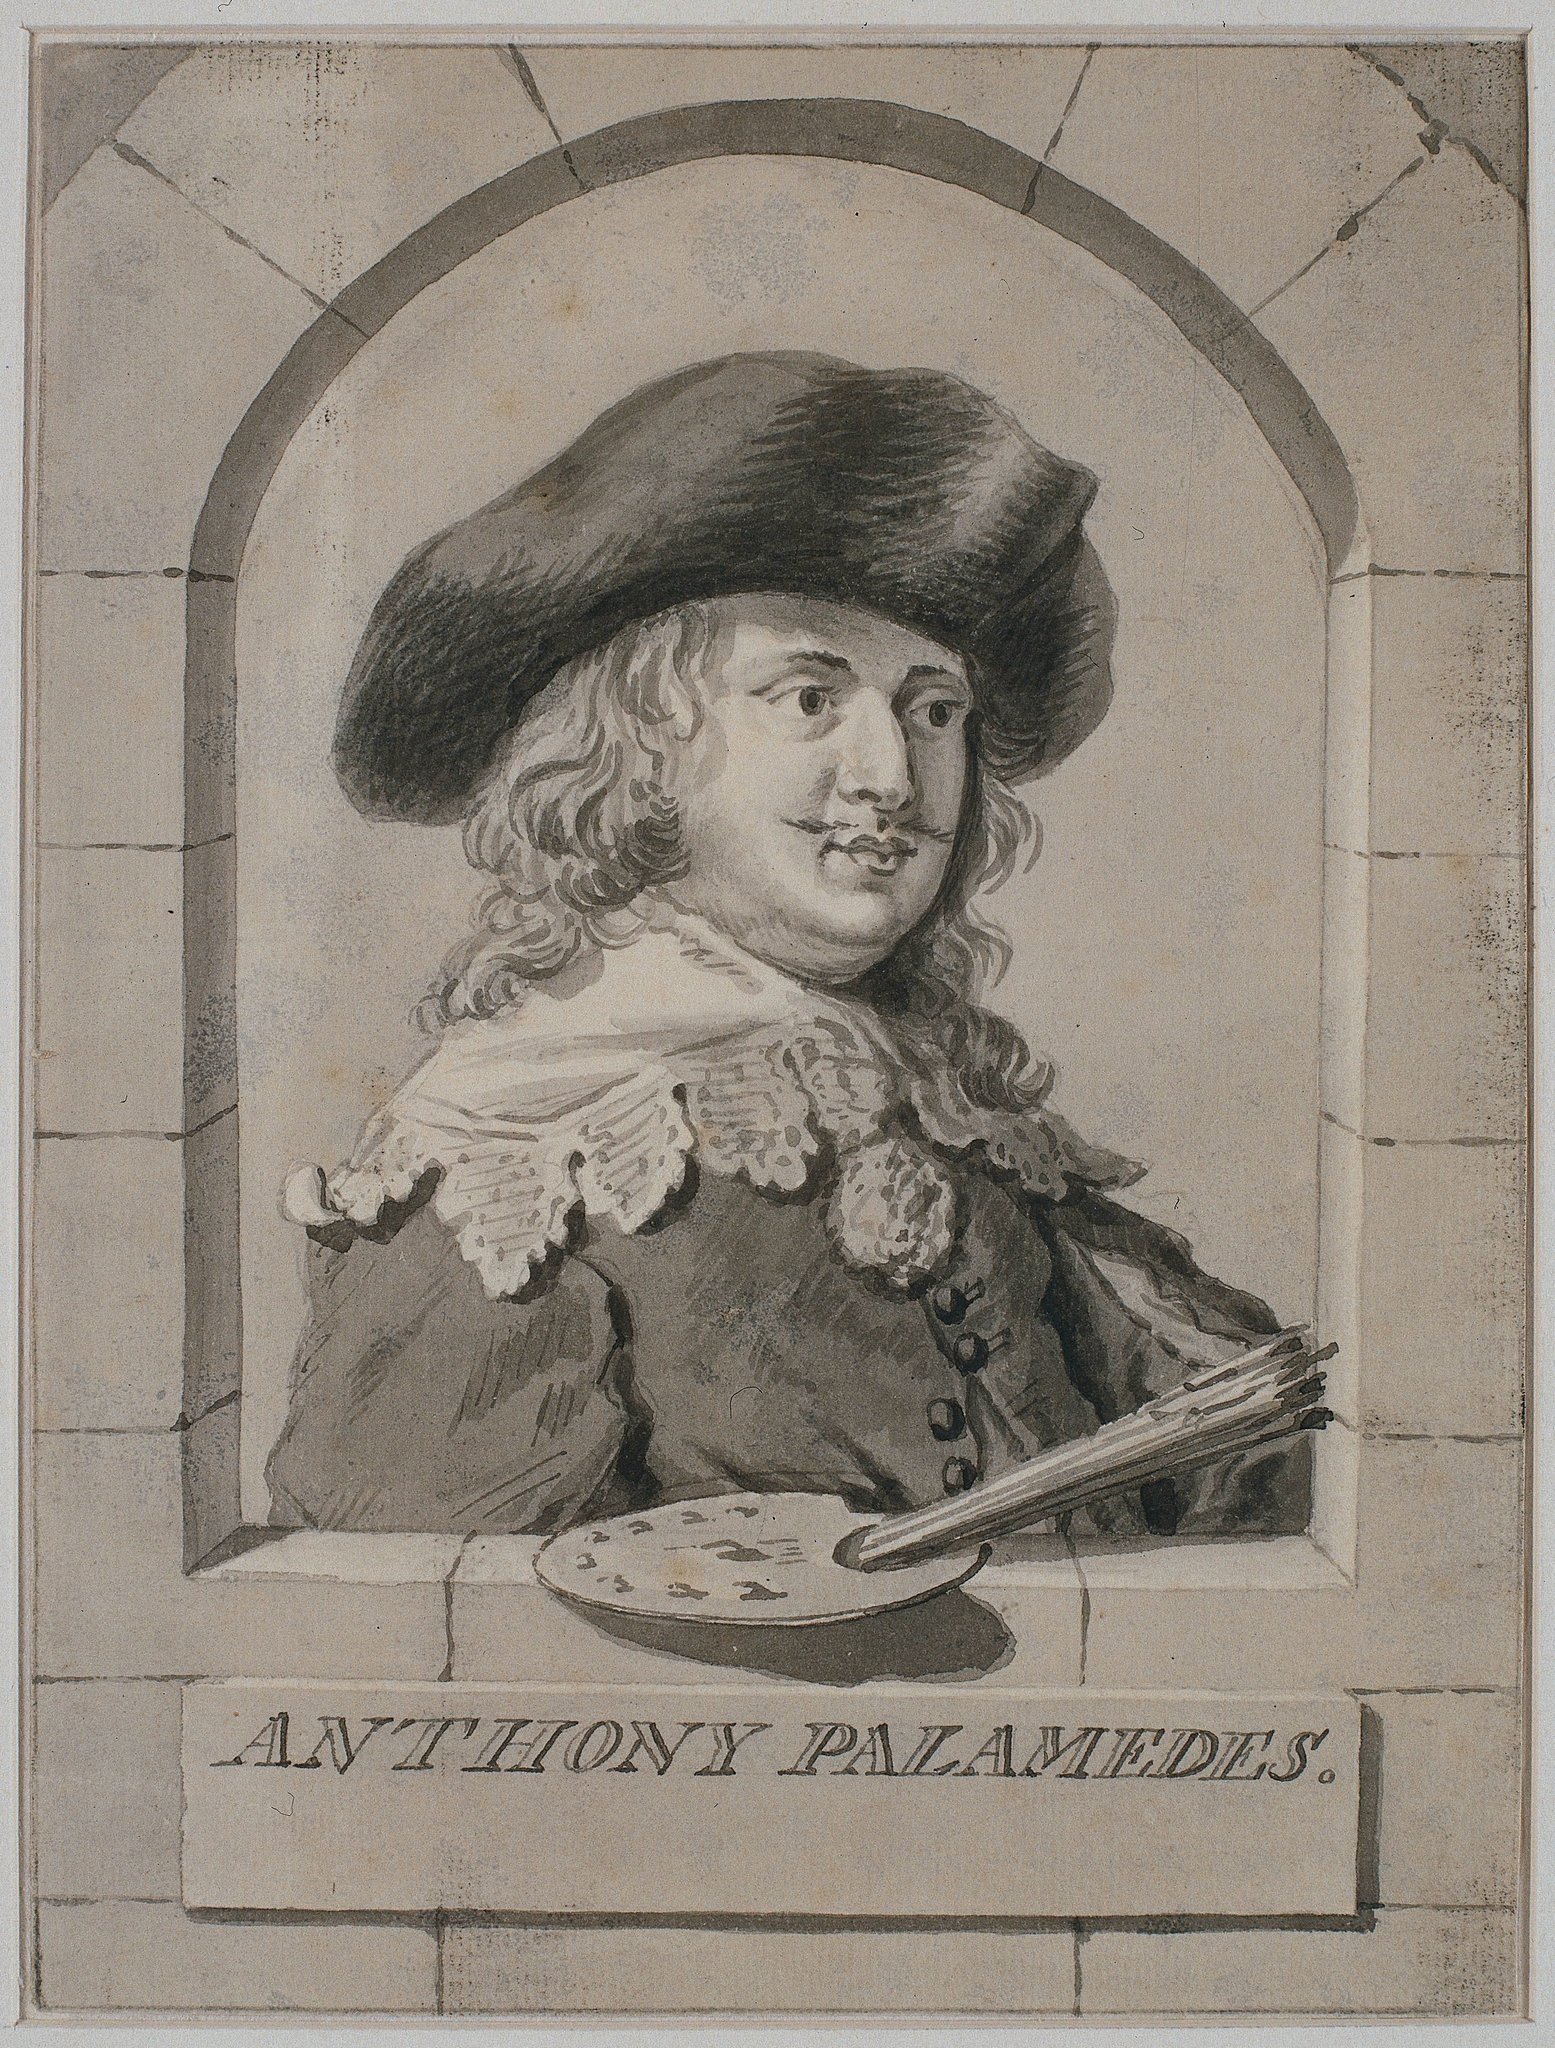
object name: drawing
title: Portret van Anthonie Palamedesz.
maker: Anonymous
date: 1611-1723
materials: paper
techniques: brush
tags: delft, amsterdam, painter, draughtsman, anthonie palamedesz, historical persons, portrait, self-portrait of painter, portrait, self-portrait of artist